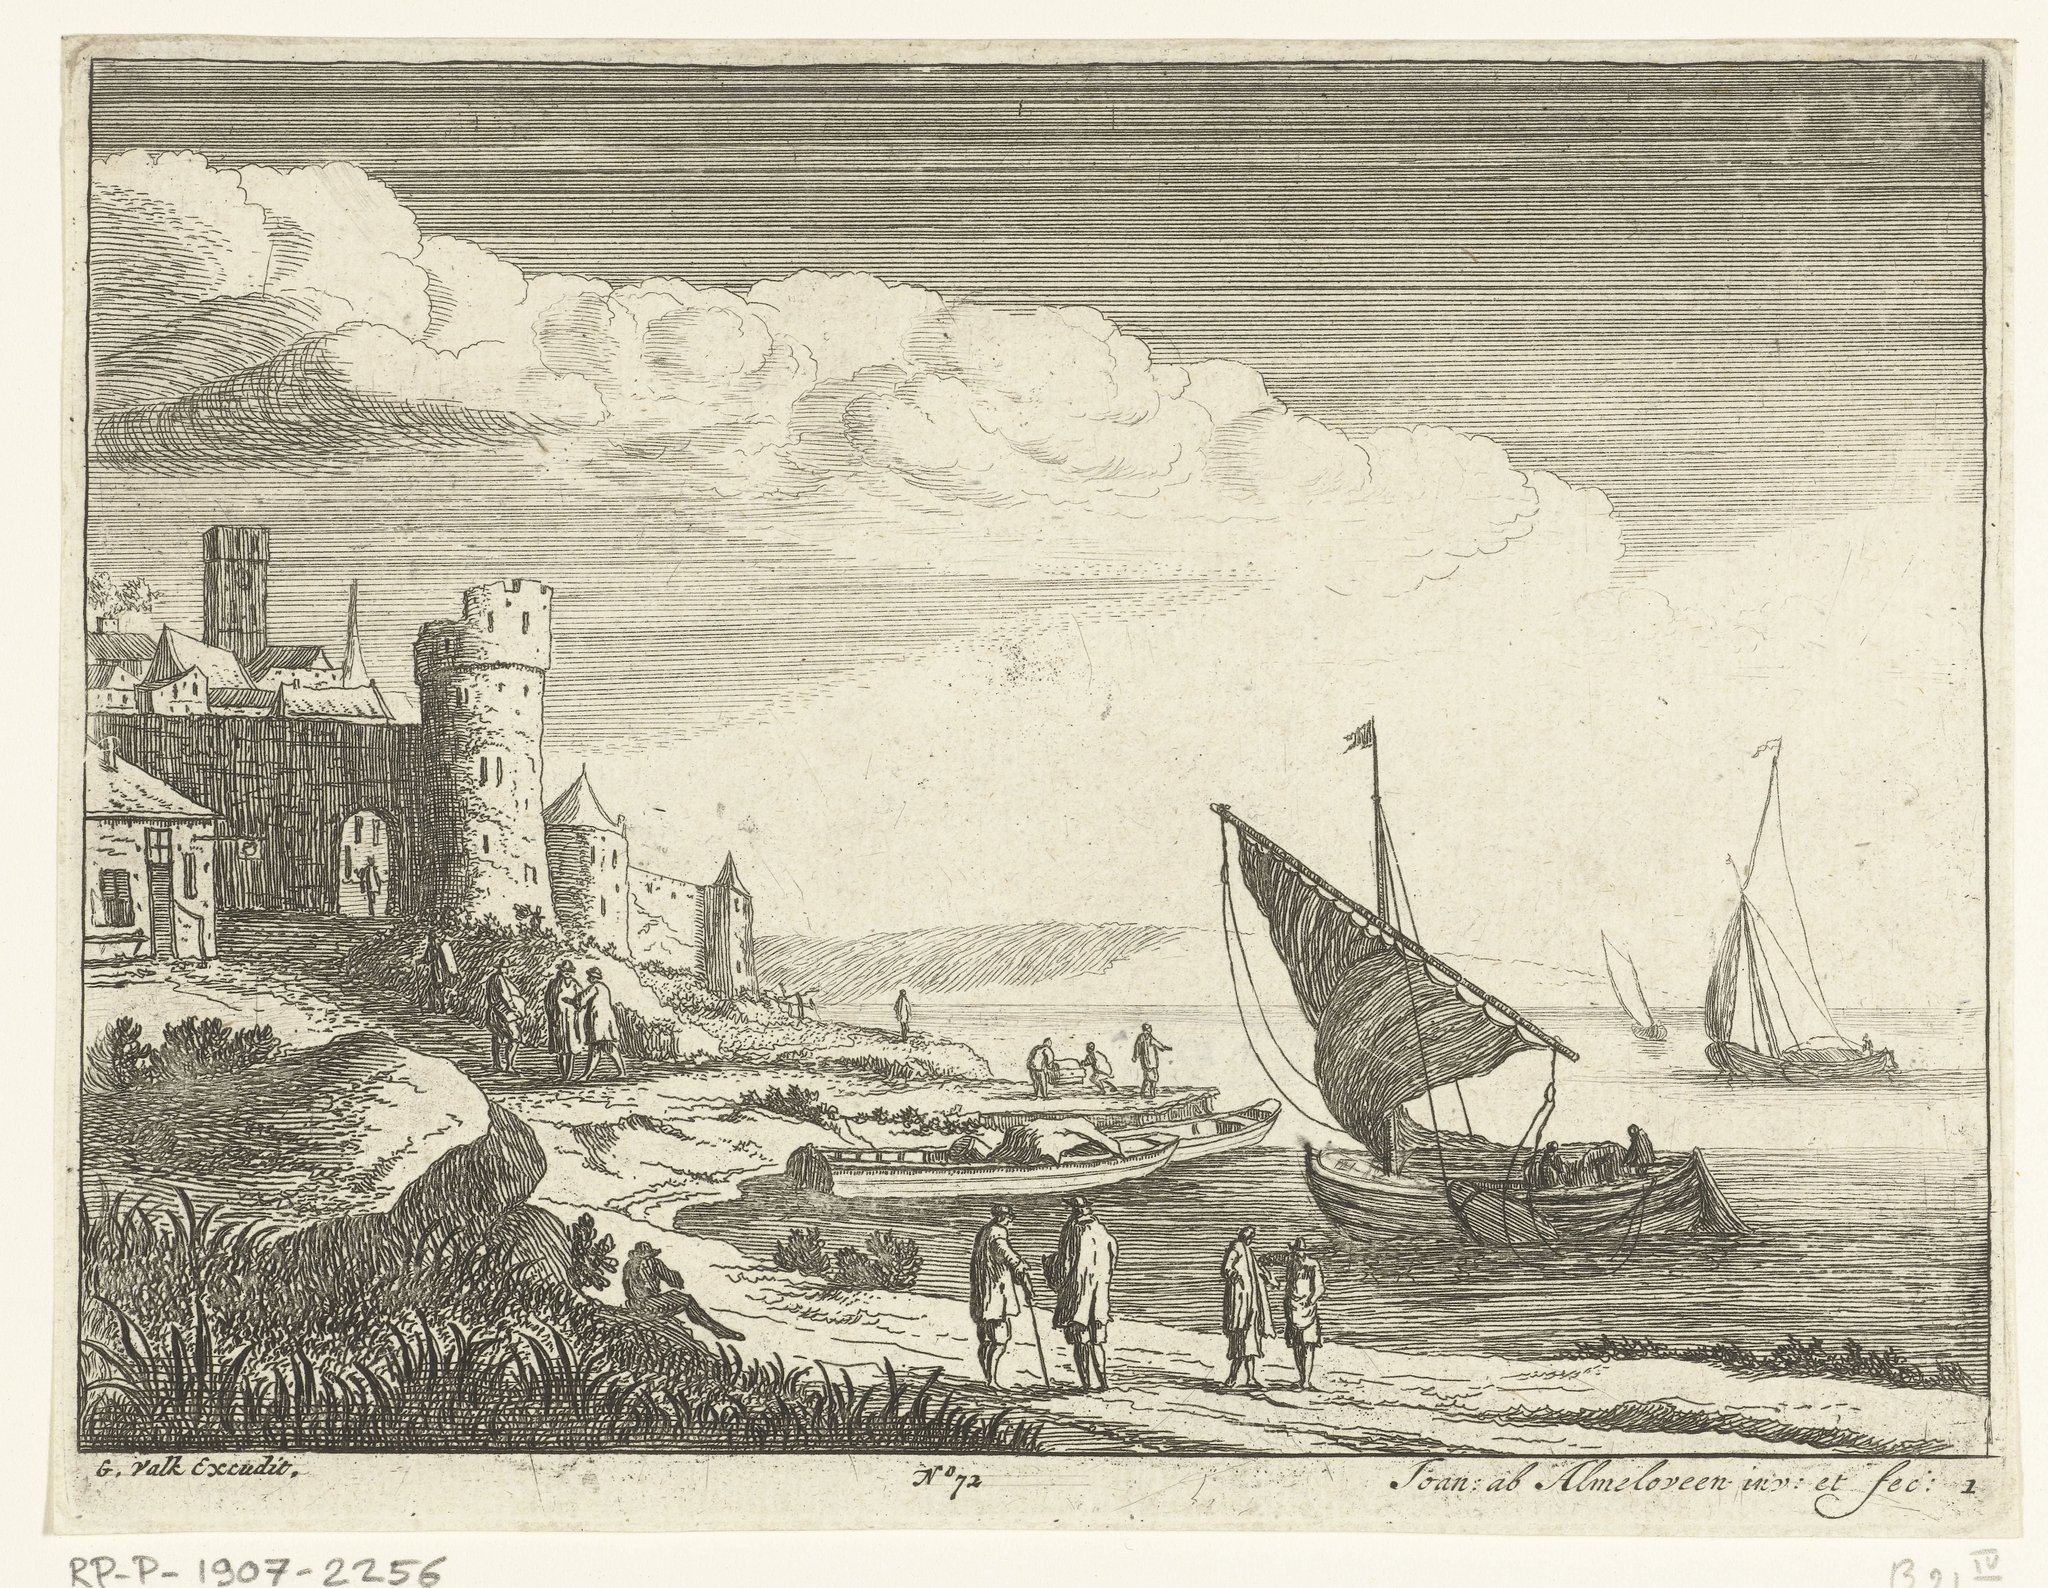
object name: print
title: Zes landschappen, eerste serie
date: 1662-1726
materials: paper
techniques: etching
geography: amsterdam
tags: ships, boats on land, beached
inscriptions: collector's mark: Lugt 2228